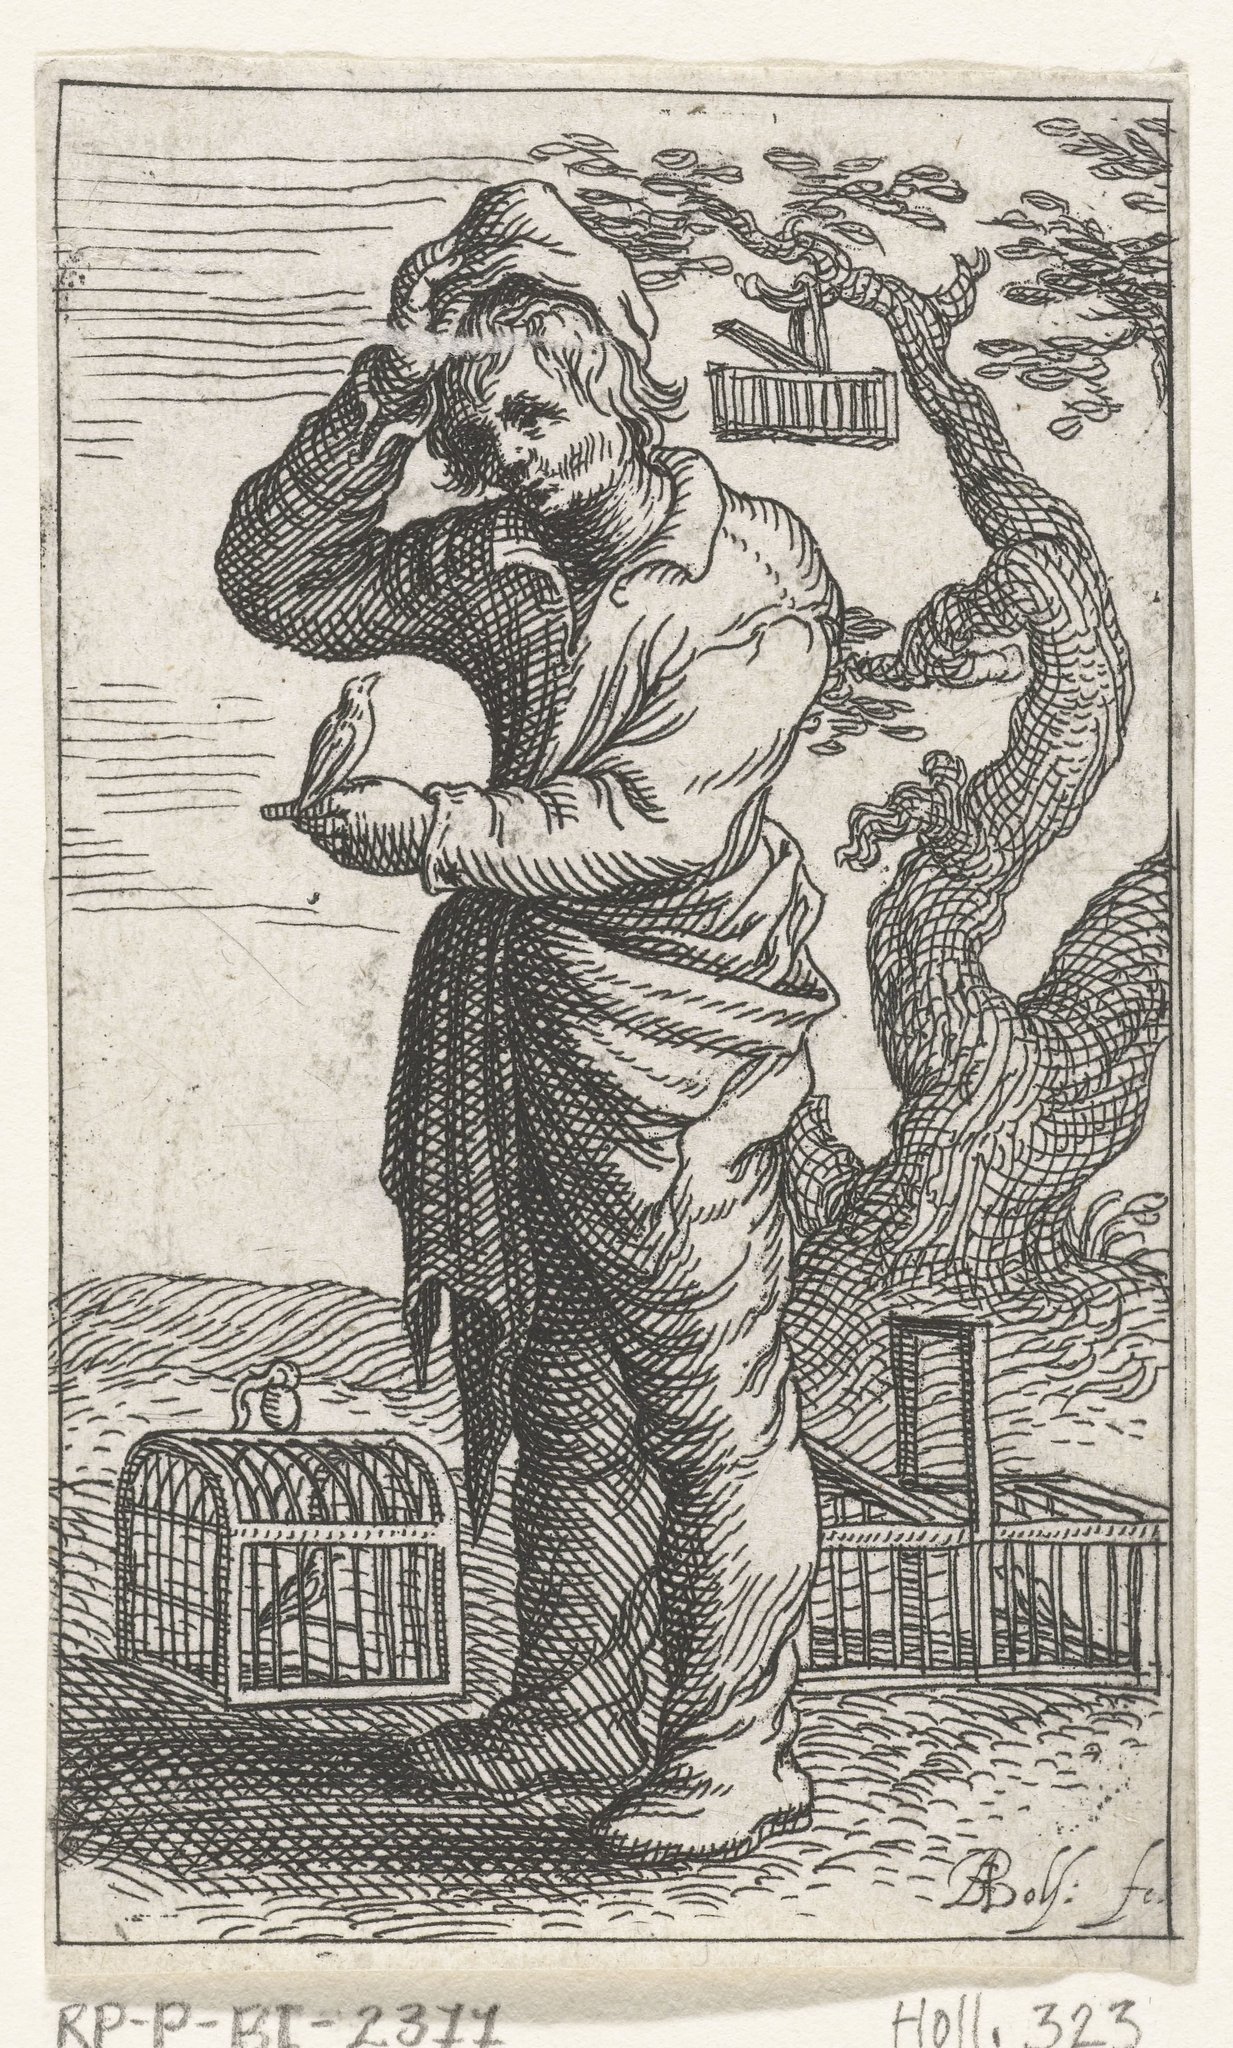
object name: print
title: Man met vogelkooien en gevangen vogels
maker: boëtius adamsz. bolswert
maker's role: print maker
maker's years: 1580-1633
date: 1590-1633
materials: paper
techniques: etching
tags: catching animals, bird in a cage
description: Volgens Roethlisberger is dit prentje niet van de hand van B.A. Bolswert en ook zeker niet naar ontwerp van Abraham Bloemaert, zie Roethlisberger 1993, p. 383, nr. 740.